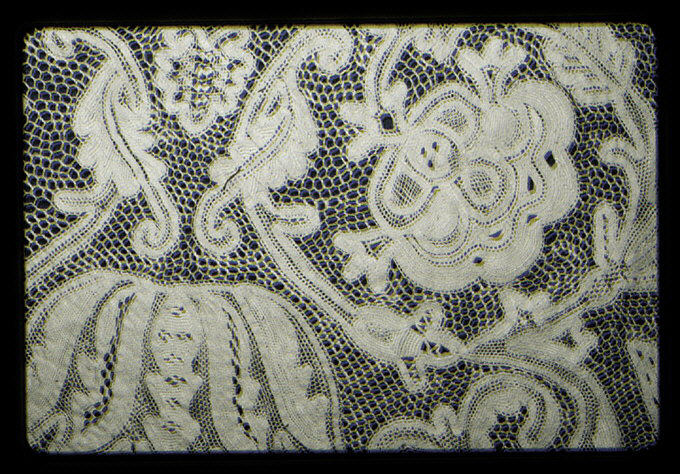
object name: border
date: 1601-1700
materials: lace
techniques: lace